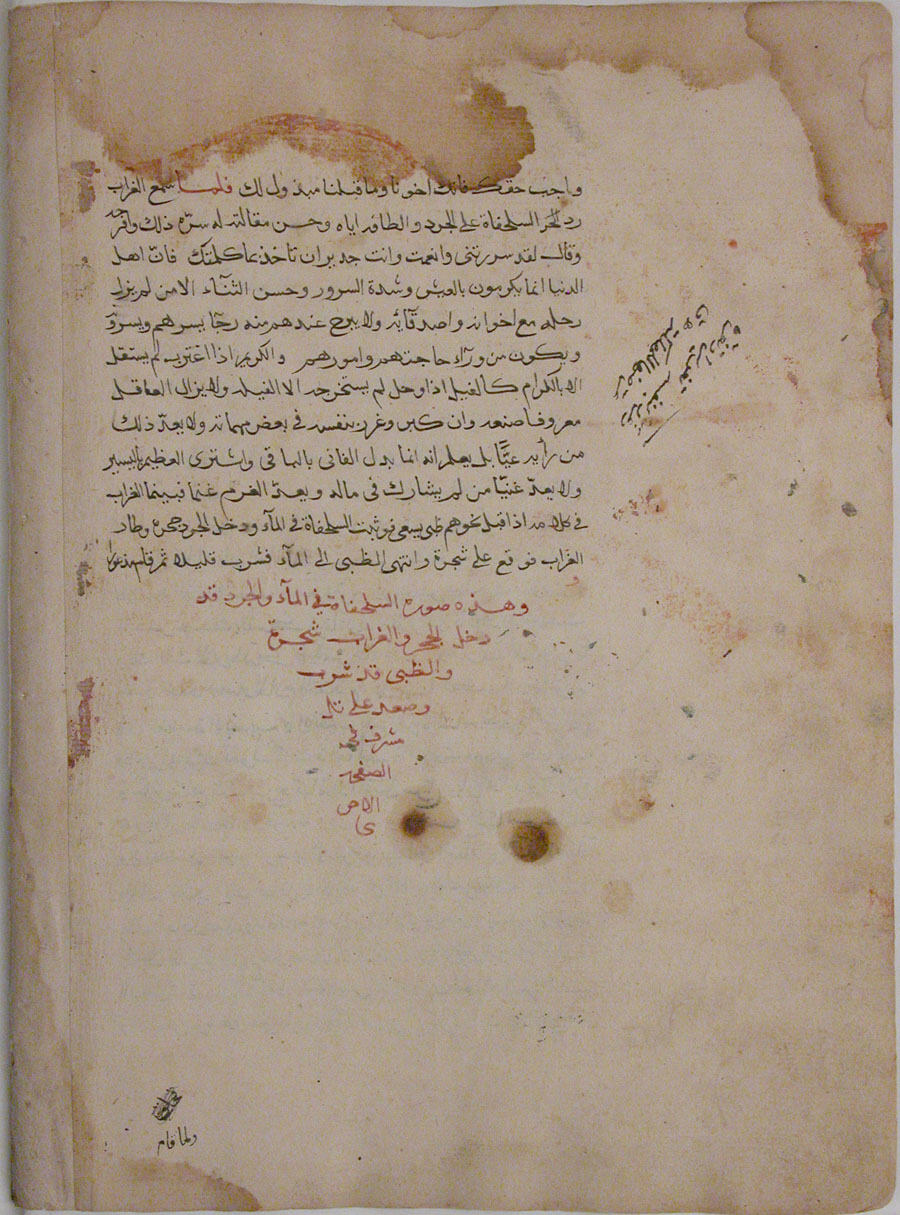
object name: folio from an illustrated manuscript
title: Page of Calligraphy from a Kalila wa Dimna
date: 1526-1550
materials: ink, paper, watercolor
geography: india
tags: arabic,calligraphy